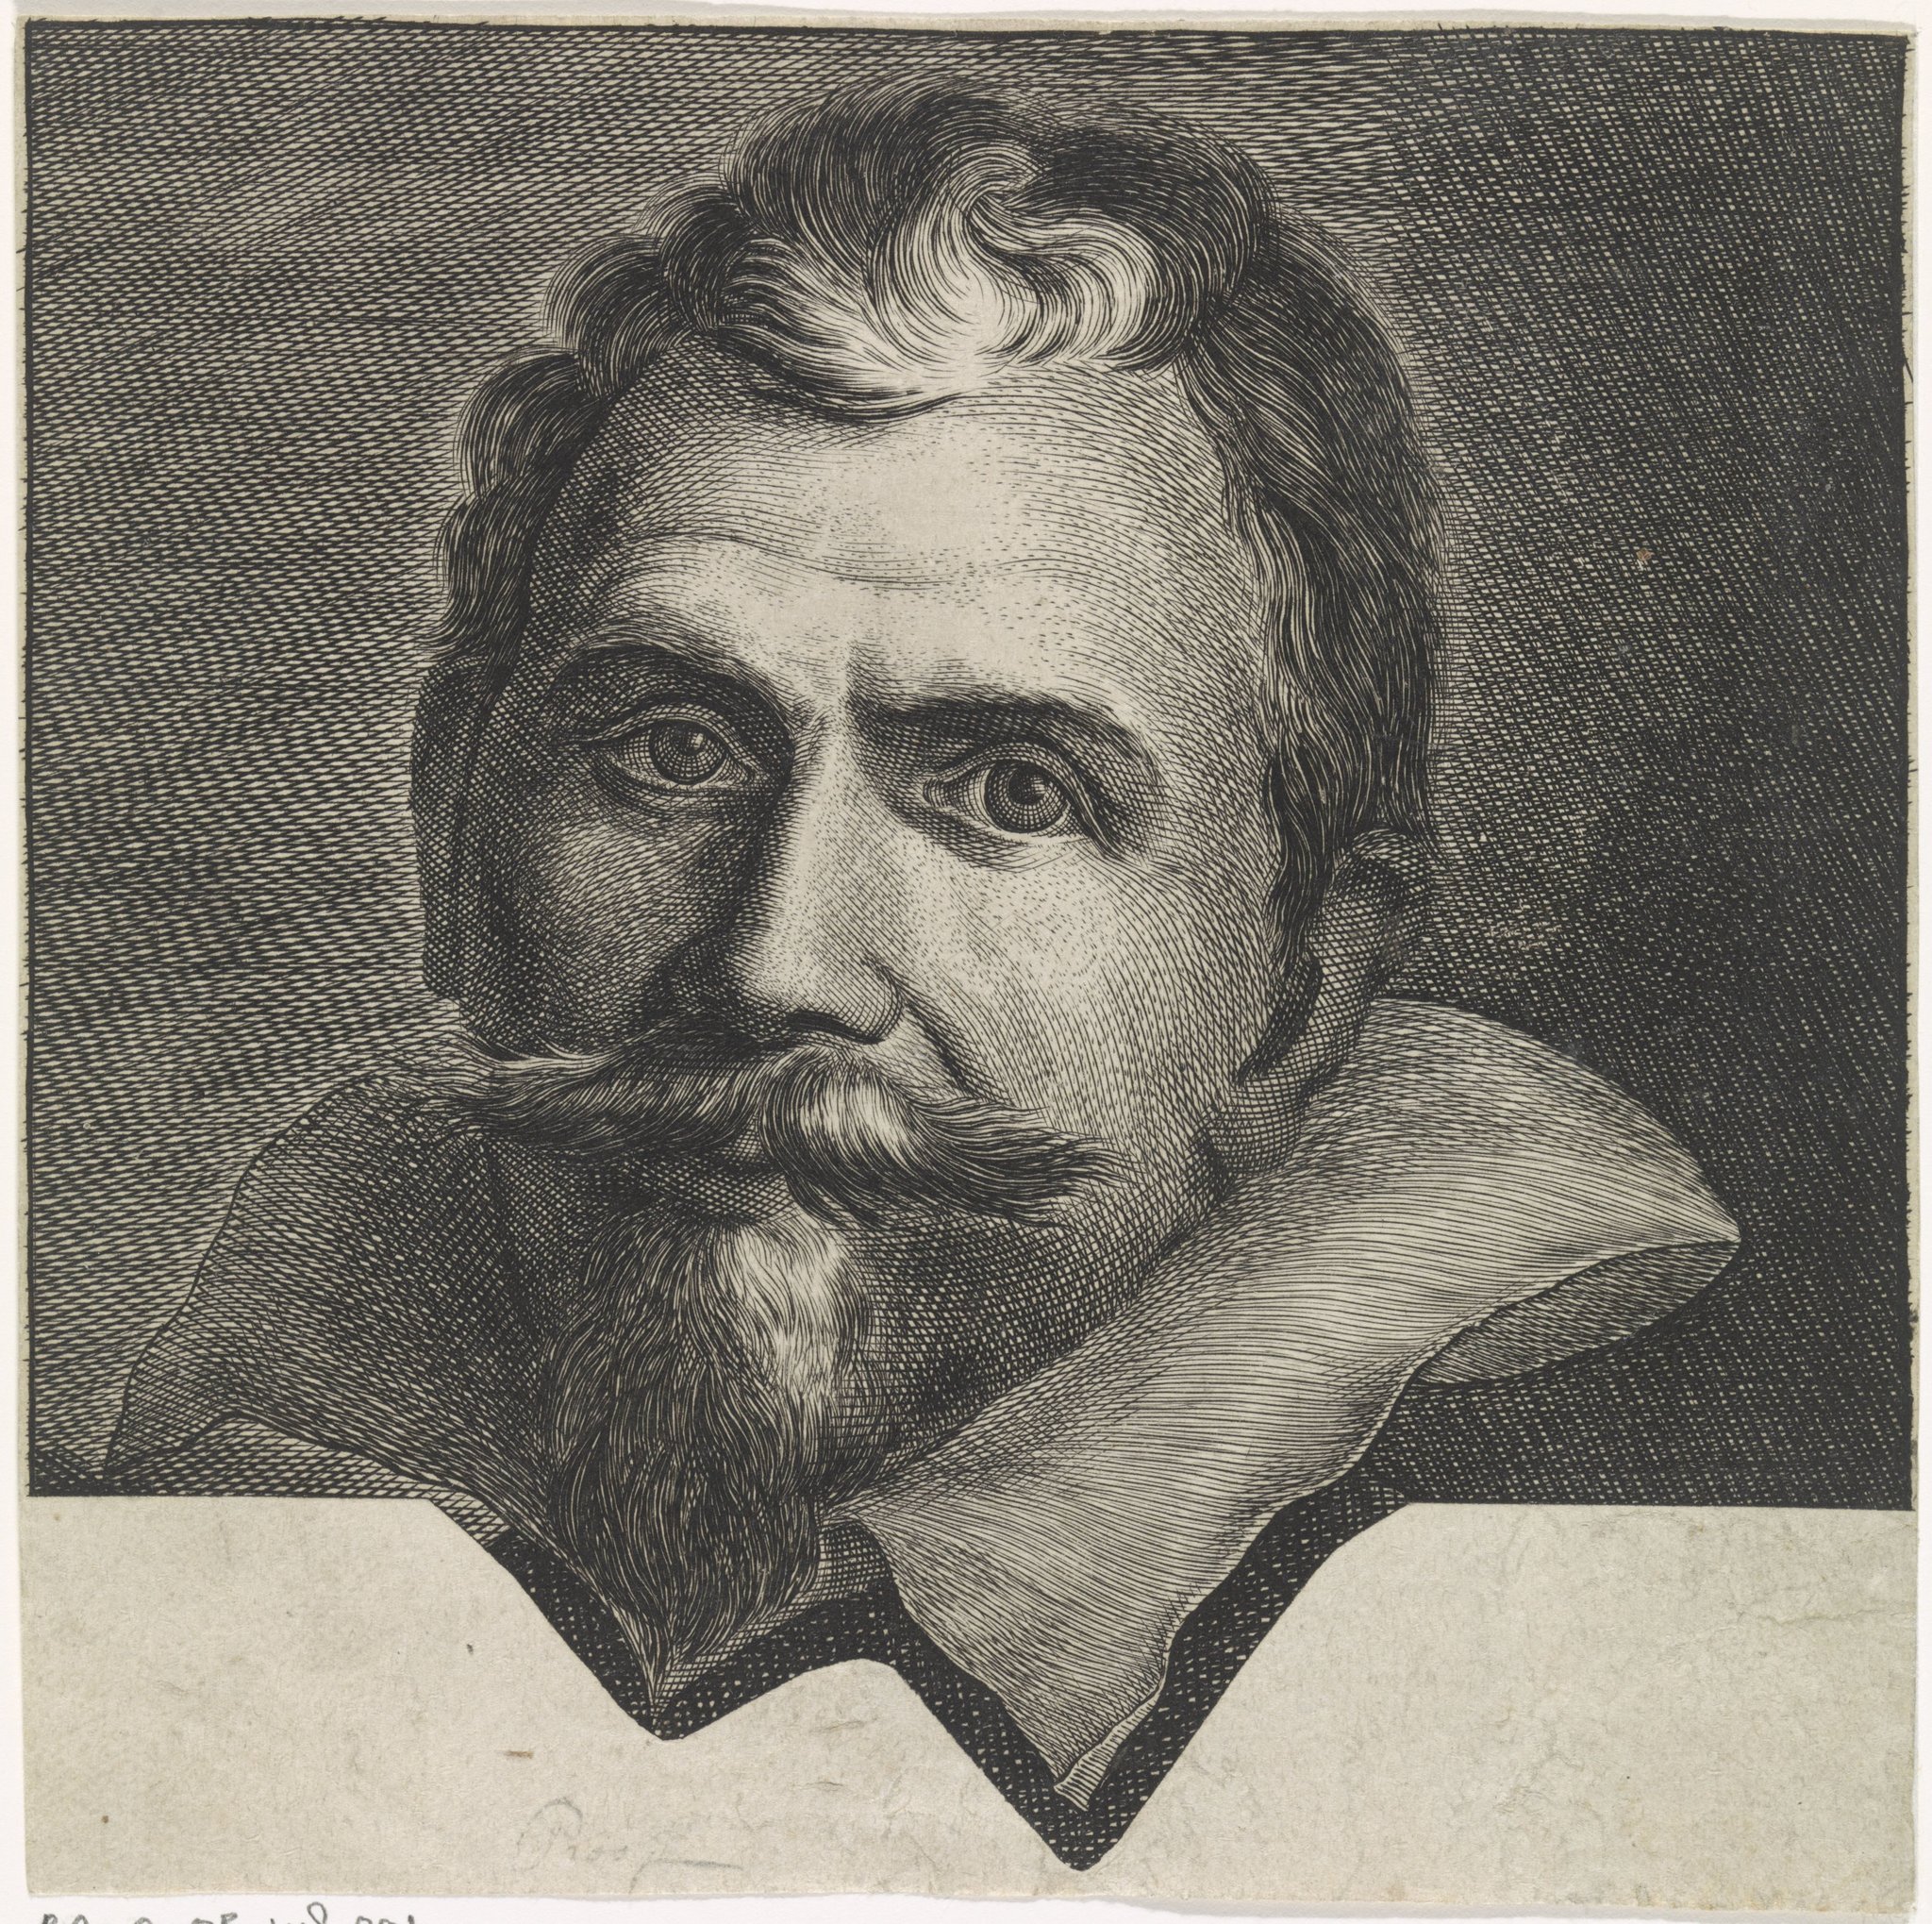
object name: print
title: Portret van Paulus Willemsz. van Vianen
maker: abraham lutma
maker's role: draughtsman, print maker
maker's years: 1624-1669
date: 1650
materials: paper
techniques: engraving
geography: amsterdam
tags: jeweler, paulus willemsz. van vianen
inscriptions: collector's mark: Lugt 2228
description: Portret van Paulus Willemsz. van Vianen, tekenaar en edelsmid.